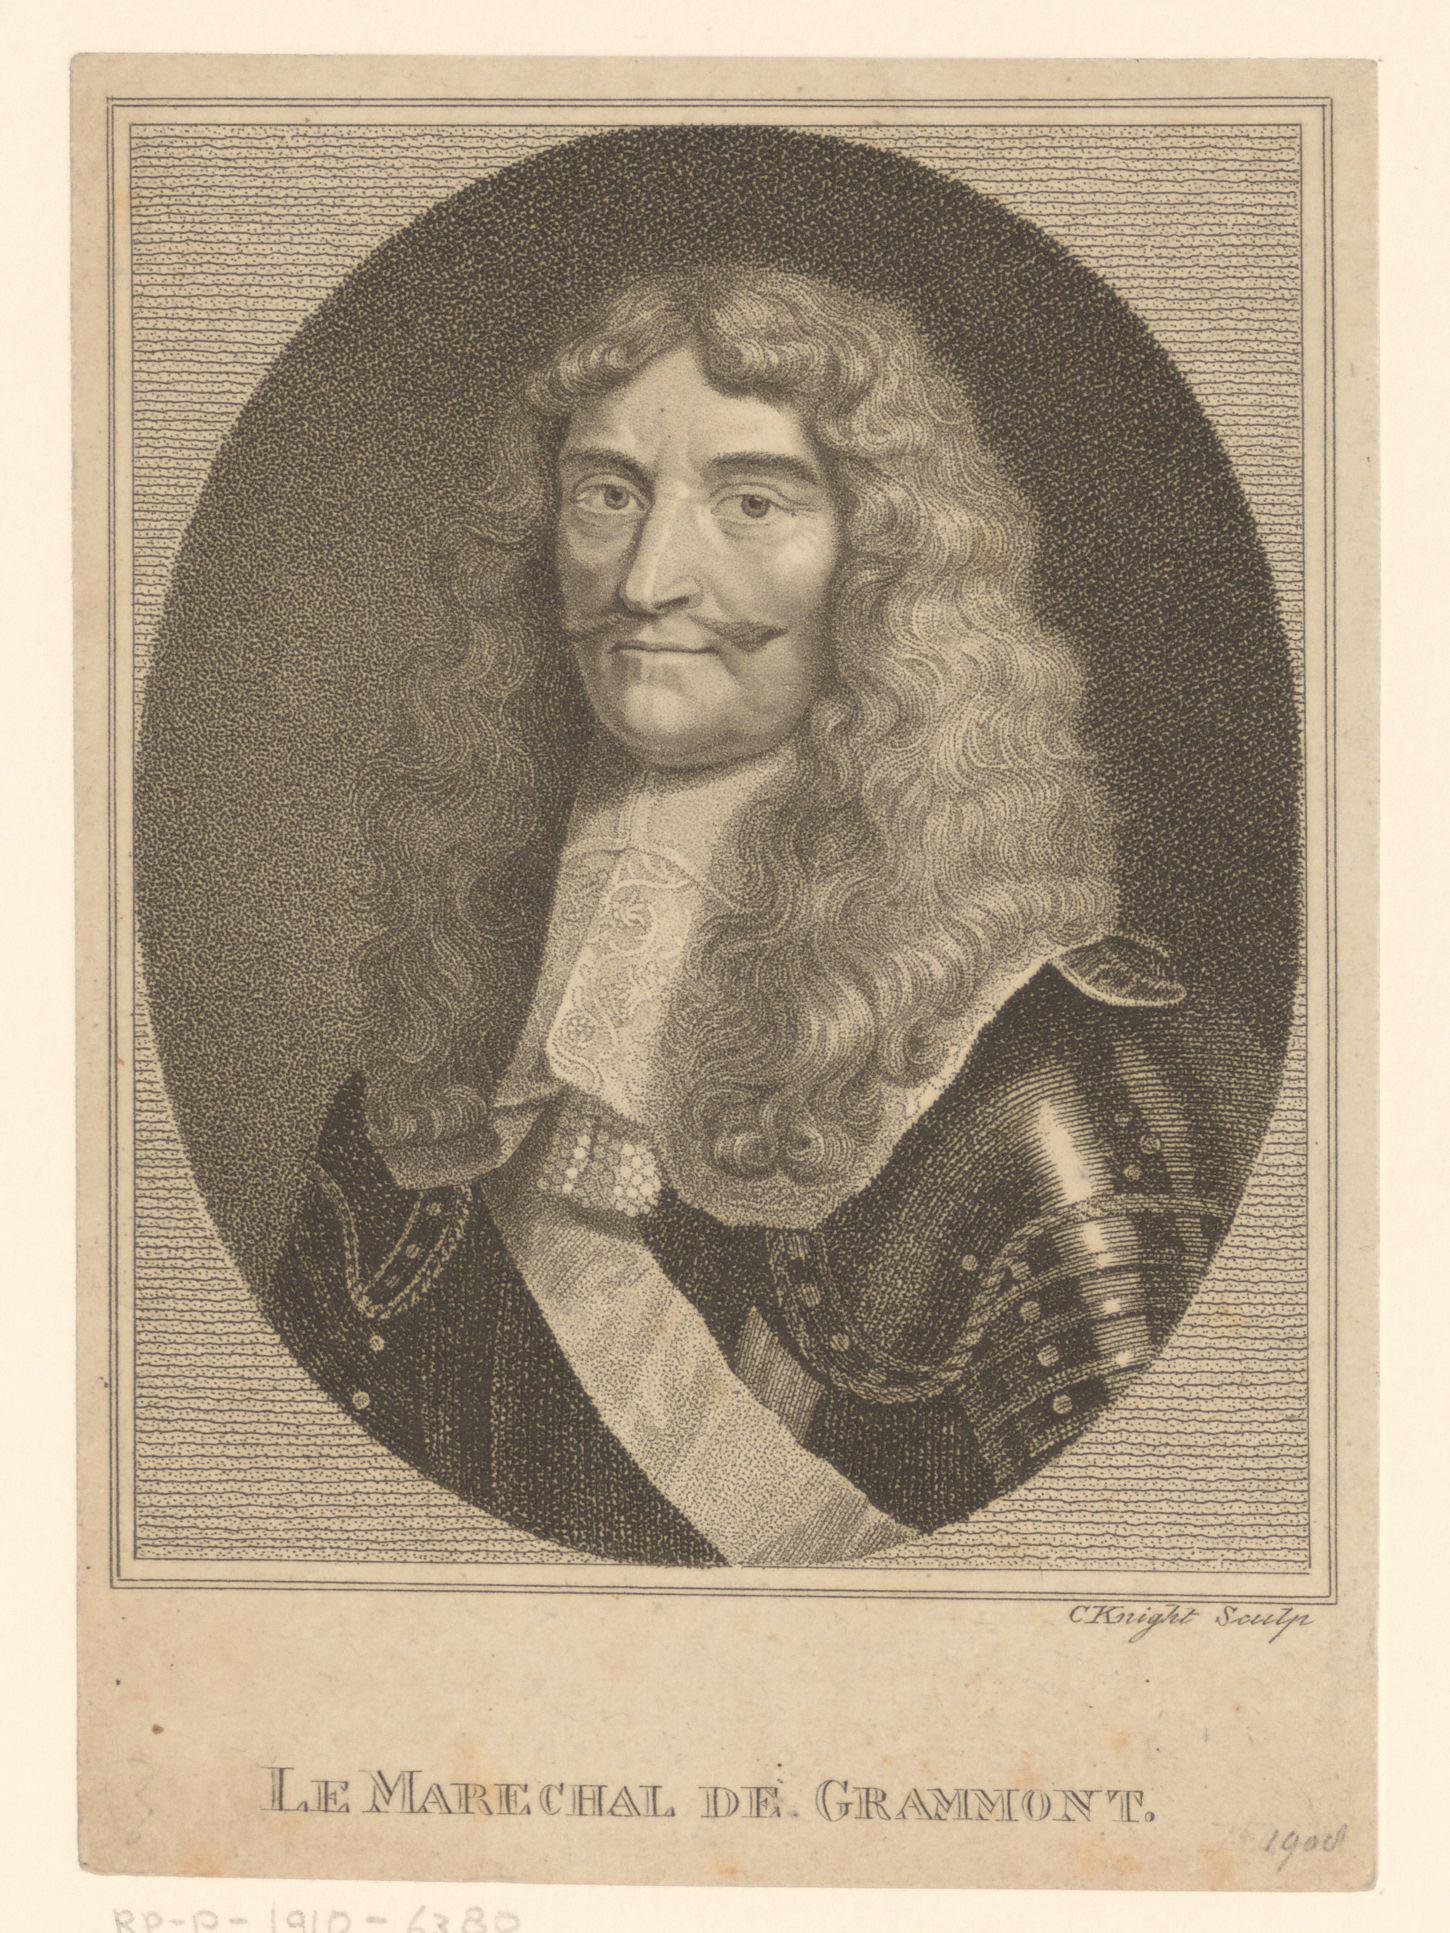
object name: print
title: Portret van Antoine III de Gramont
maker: charles knight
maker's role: print maker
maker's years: 1743-1826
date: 1753-1826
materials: paper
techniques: etching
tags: france, historical persons, officer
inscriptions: collector's mark: Lugt 2228